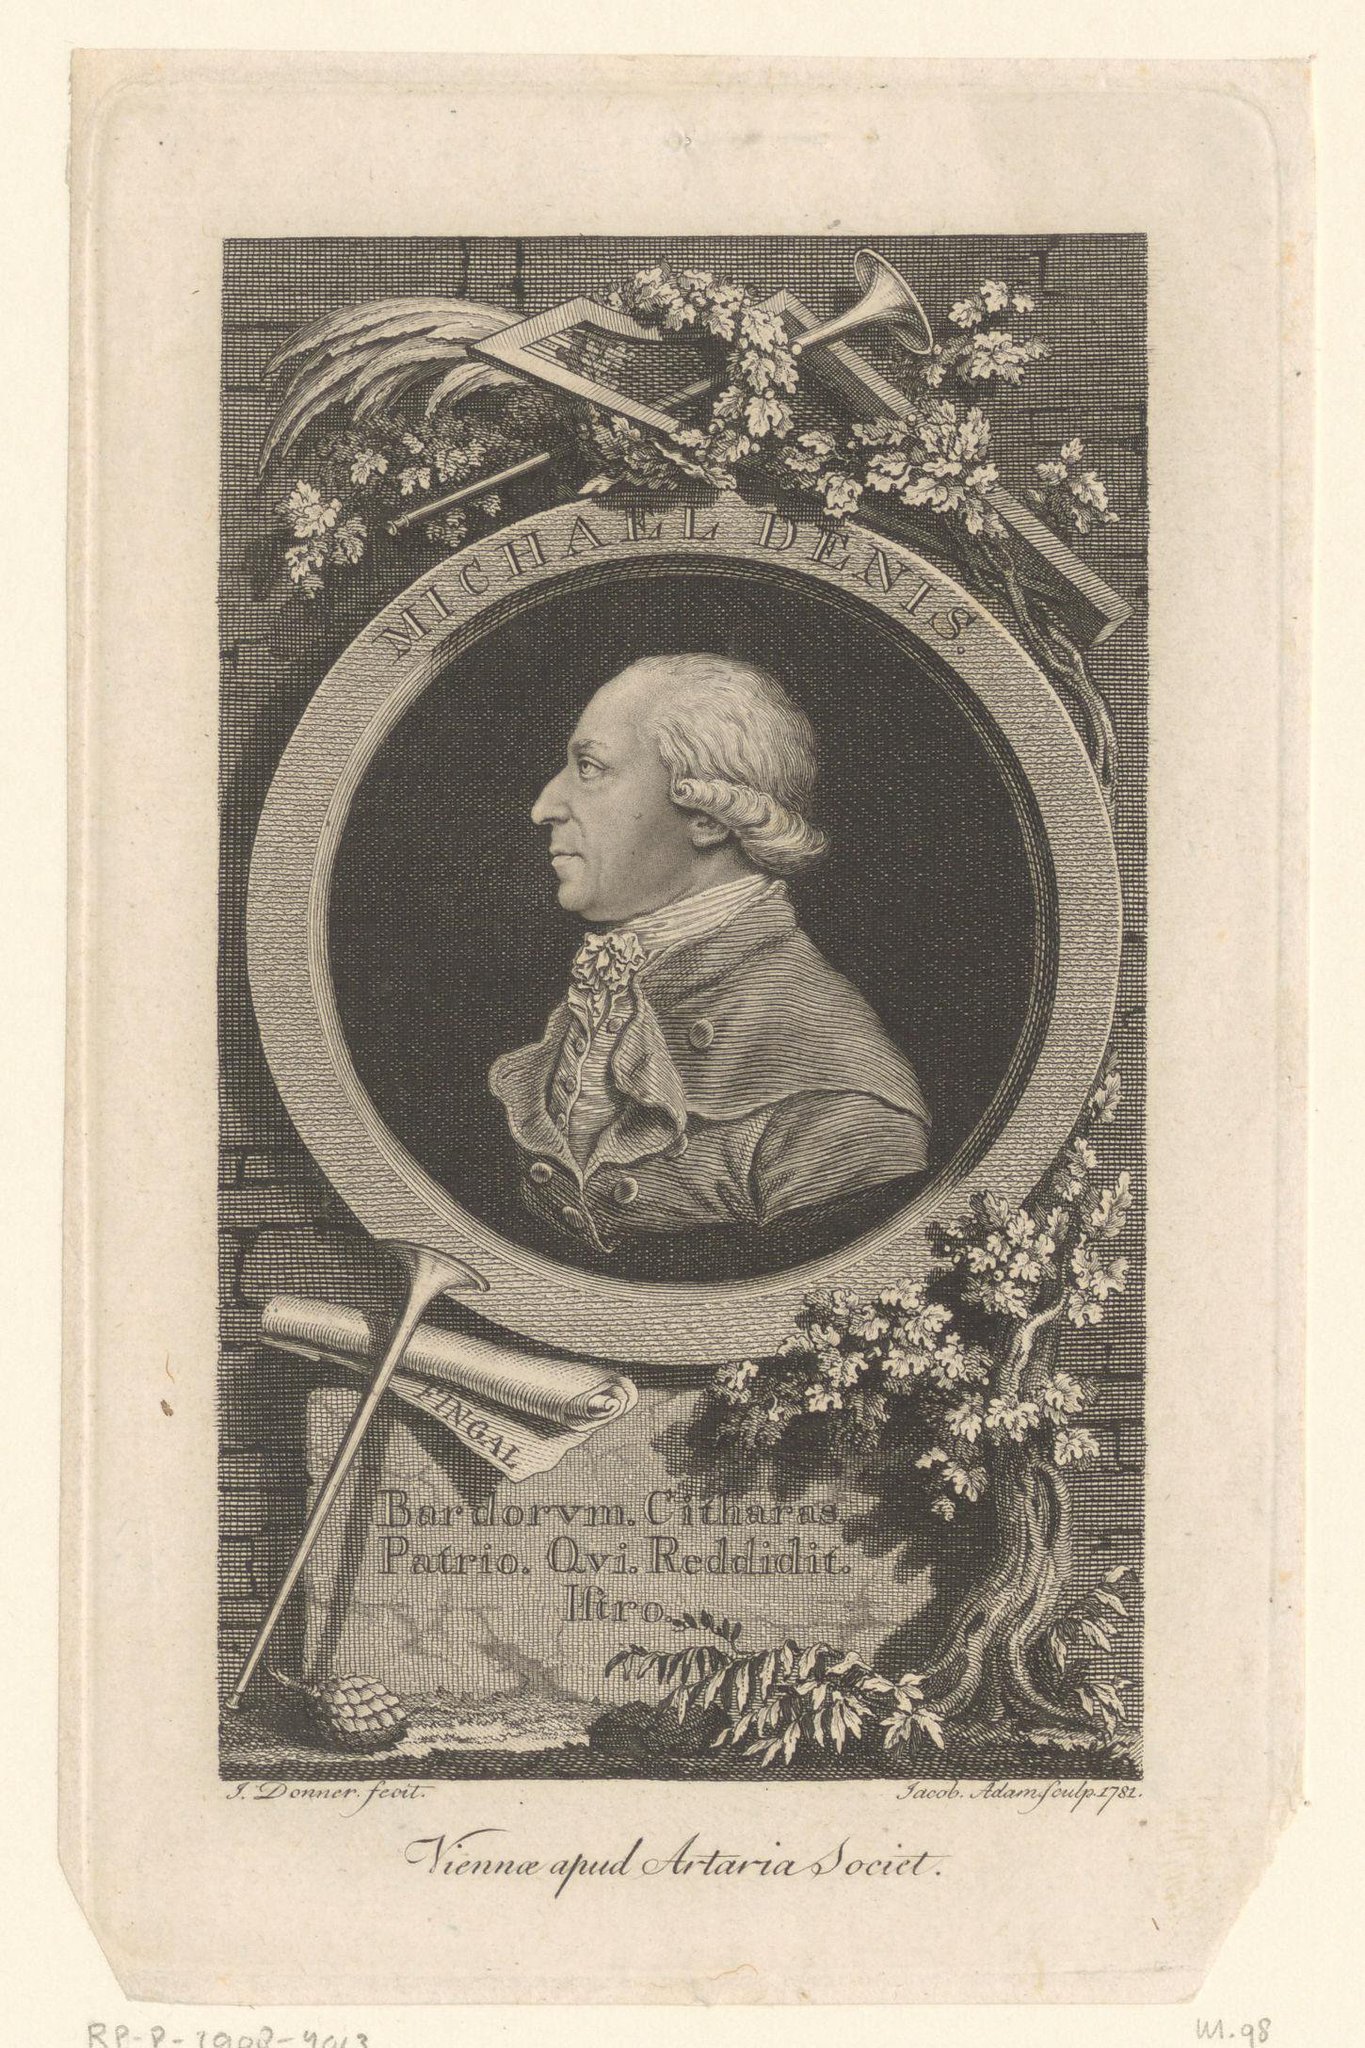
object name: print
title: Michael Denis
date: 1781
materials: paper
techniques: etching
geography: vienna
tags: priest, historical persons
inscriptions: collector's mark: Lugt 2228